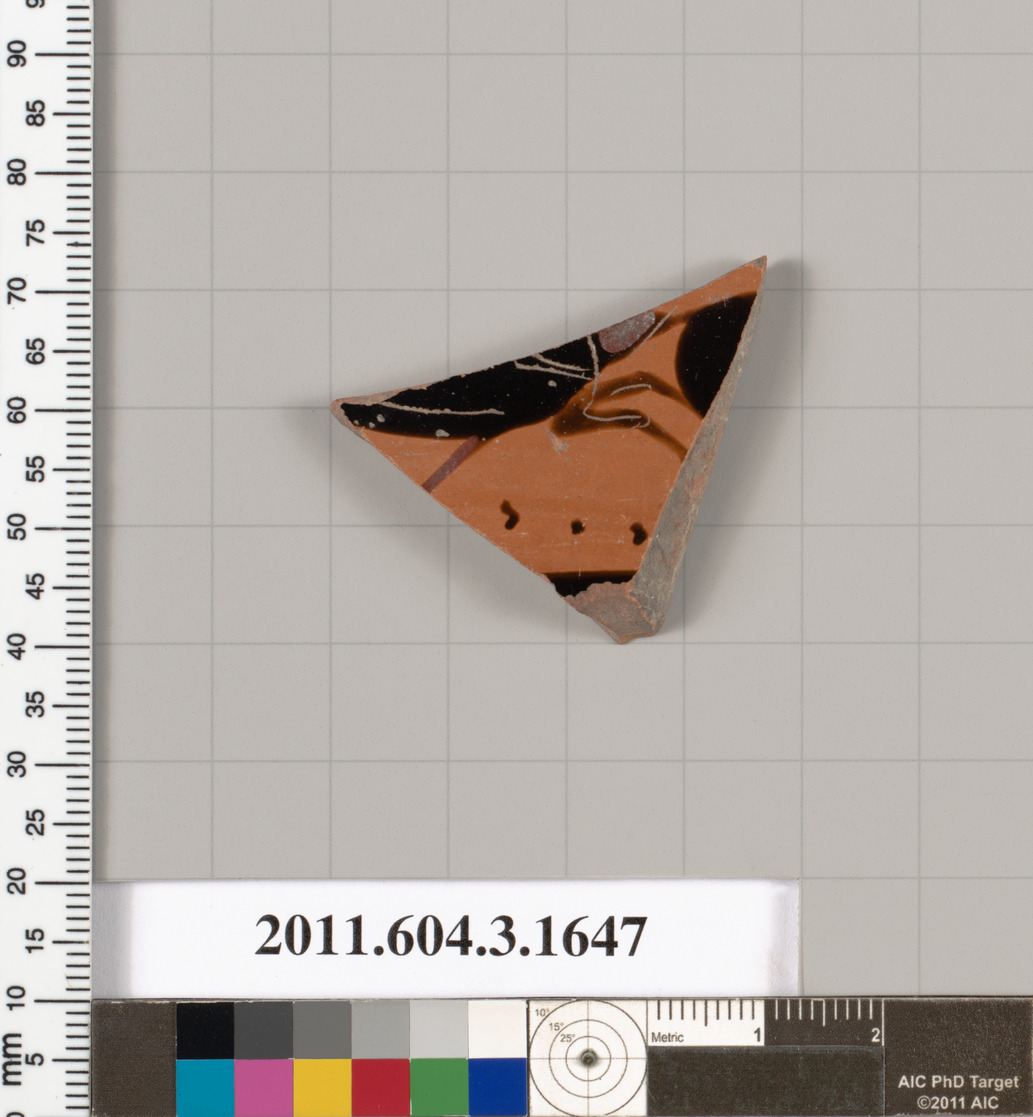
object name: kylix fragment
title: Terracotta fragment of a kylix: Band cup (drinking cup)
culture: greek, attic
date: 550-526 BCE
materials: terracotta